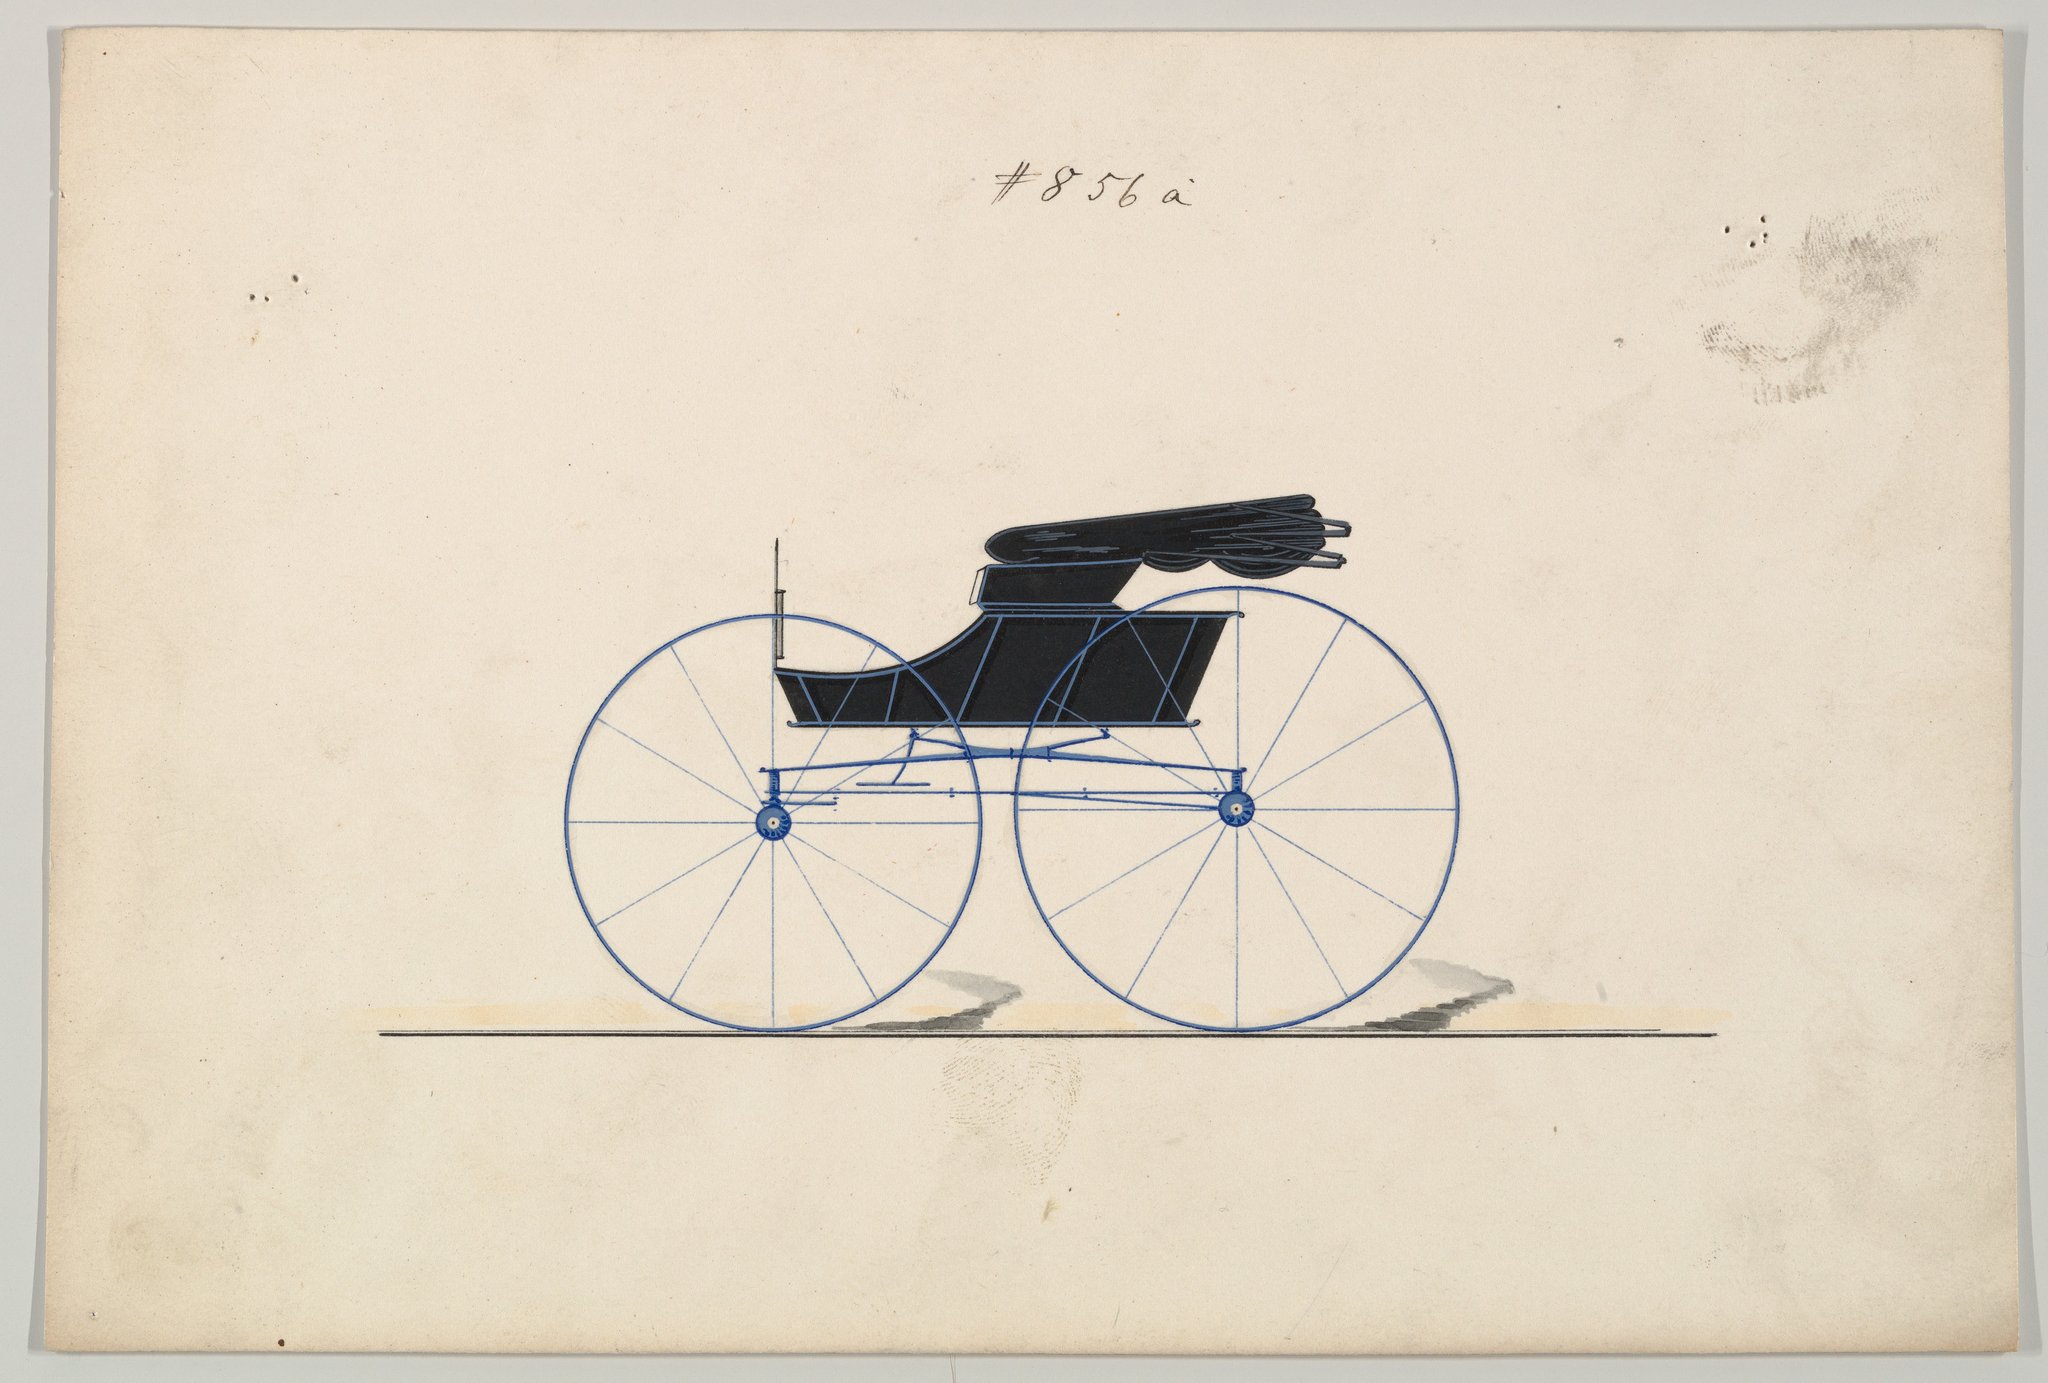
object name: drawing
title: Design for Wagon, no. 856a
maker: brewster & co.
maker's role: manufacturer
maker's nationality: american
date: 1860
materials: gouache, gum arabic, ink, watercolor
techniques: pen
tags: carriages